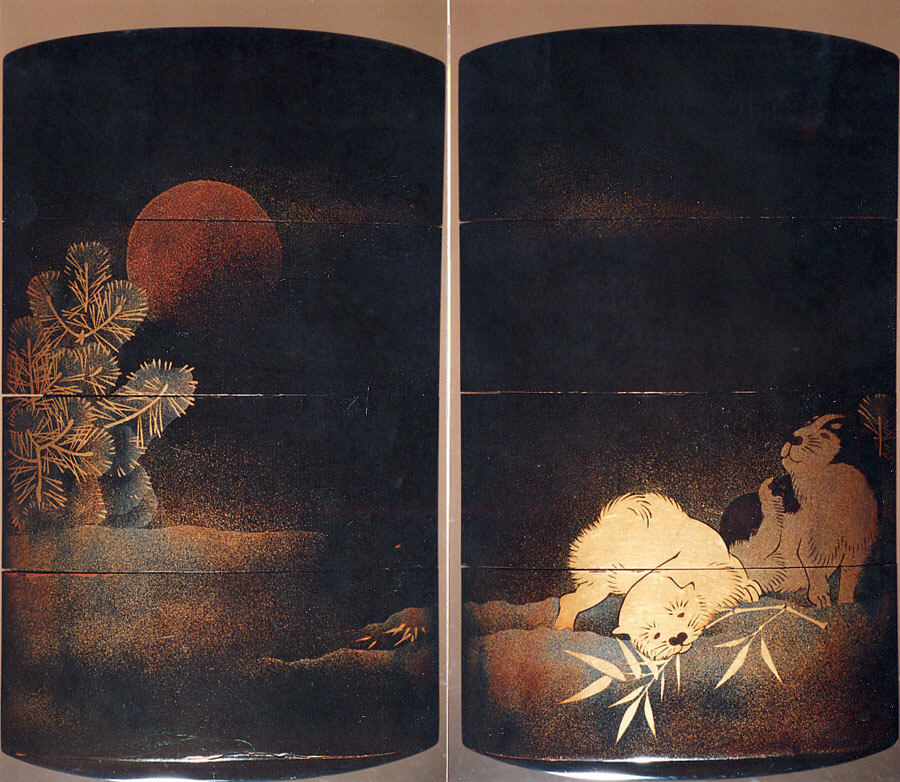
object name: inrō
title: Case (Inrō) with Design of Two Puppies Playing with a Bamboo Branch (obverse); Snow, Pine and Red Sun (reverse)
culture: japanese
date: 1801-2000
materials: gold, lacquer, silver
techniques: fundame, roiro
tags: dogs,sun,trees,snow